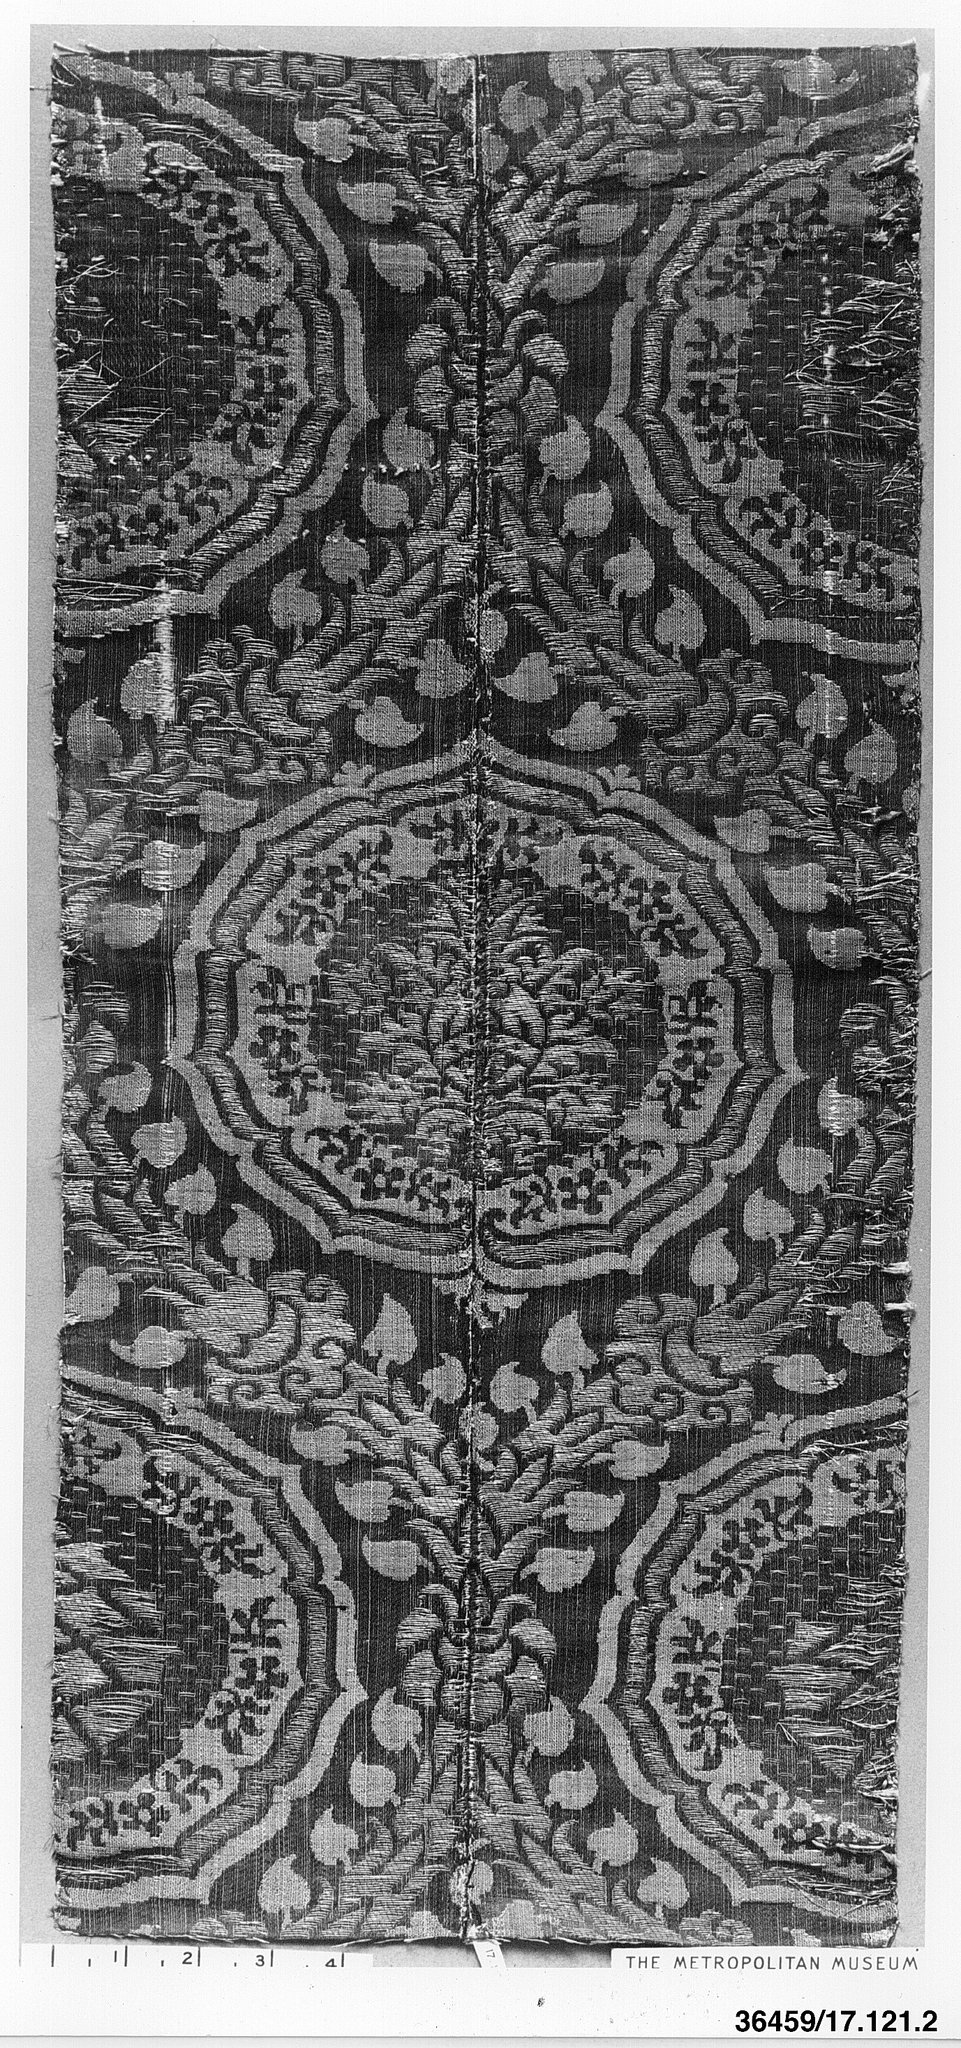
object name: piece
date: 1501-1600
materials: metal thread, silk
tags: flowers,leaves